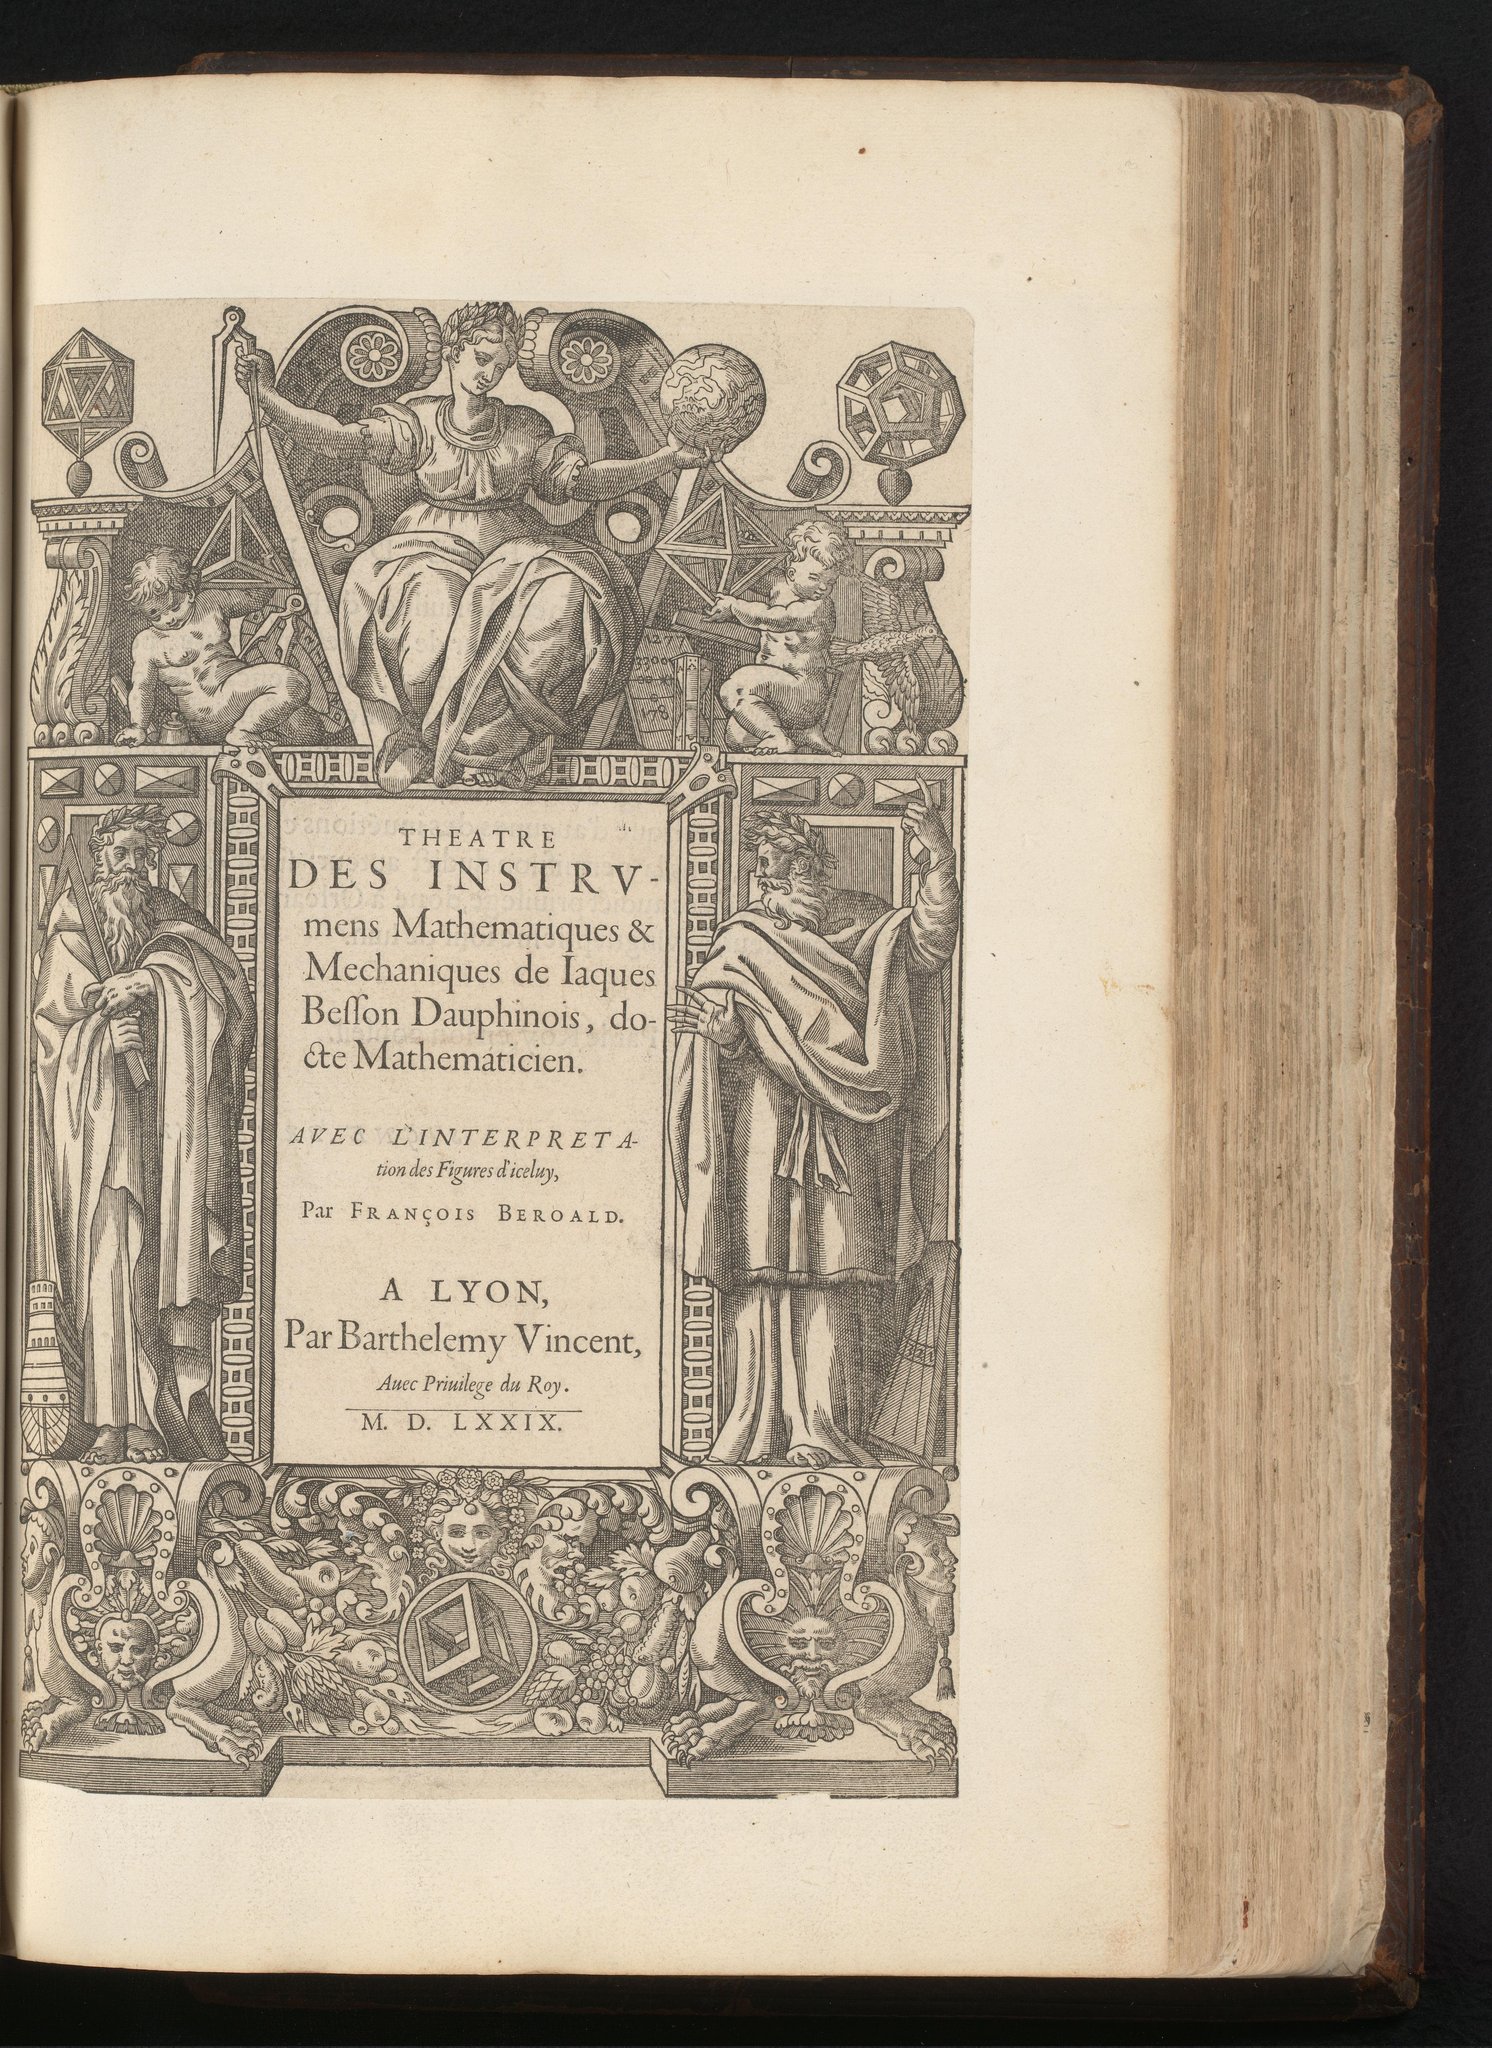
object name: titelblad, titelpagina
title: Titelpagina voor: Jacques Besson, Theatre des instrumens mathematiques & mechaniques, 1579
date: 1579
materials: paper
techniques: letterpress printing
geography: lyon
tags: measuring-instruments, compasses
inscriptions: date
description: Met een omlijsting met midden boven de personificatie van Astronomie en/of Meetkunde en links en rechts mannen met meetkundige instrumenten. Publicatie maakt deel uit van een convoluut.